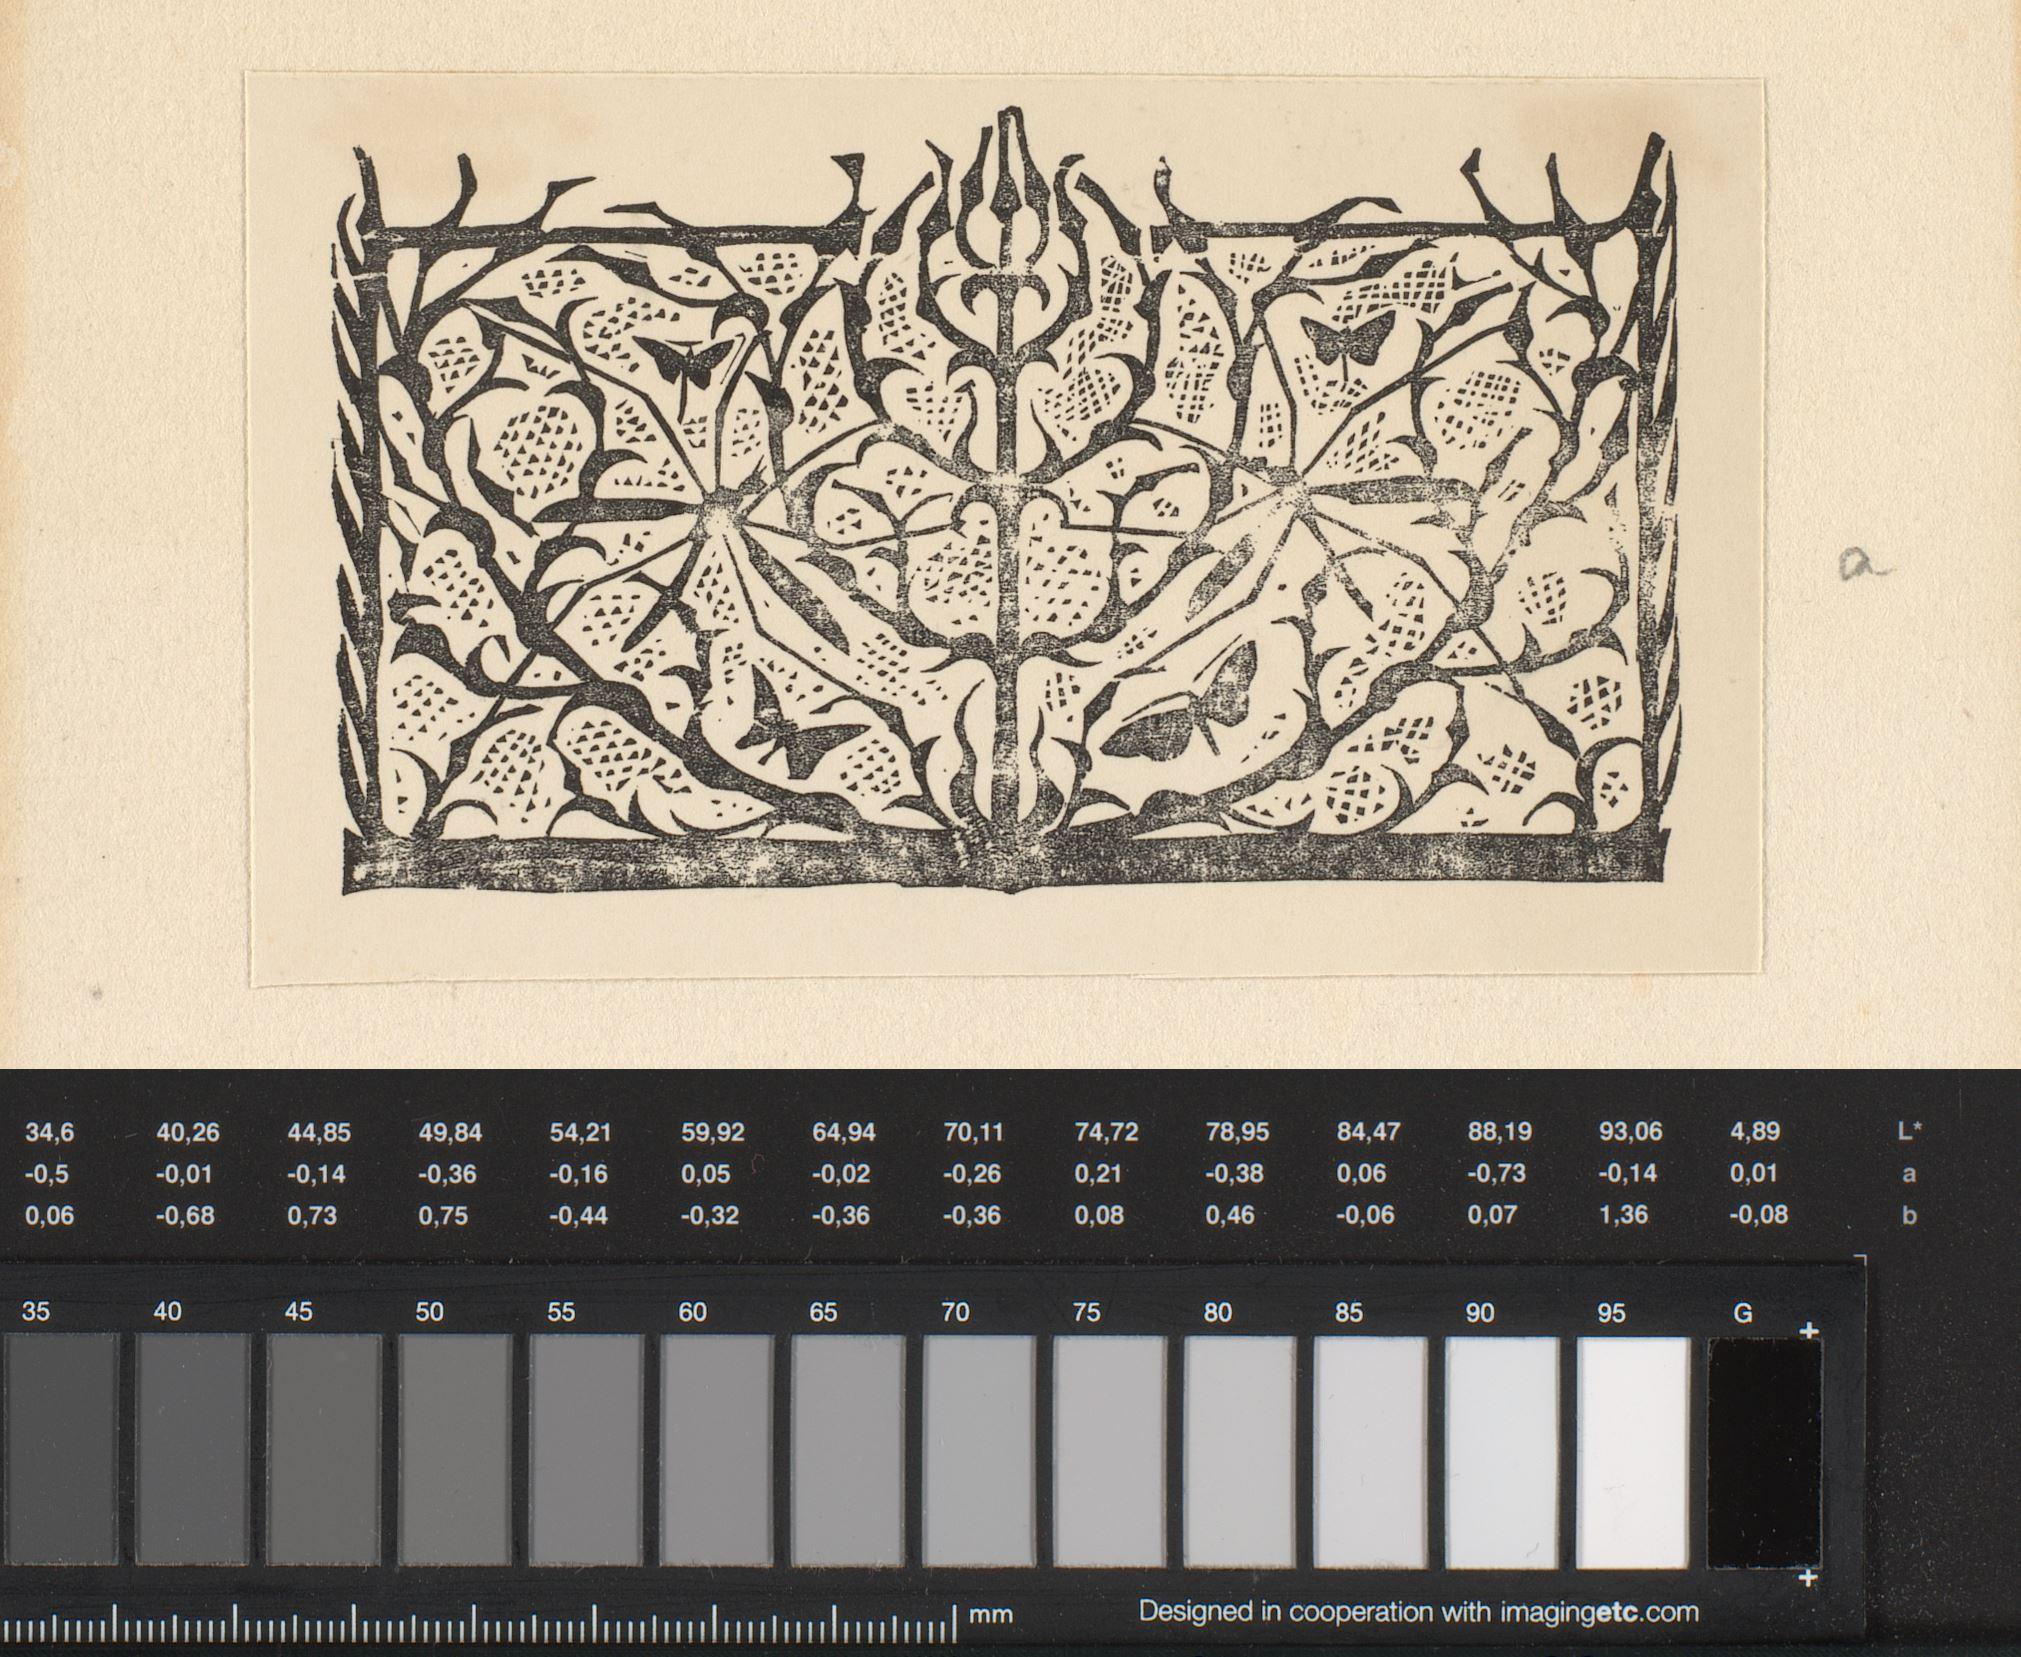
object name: print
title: Titelhoofd met langpootmuggen en motten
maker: gerrit willem dijsselhof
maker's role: designer, draughtsman, print maker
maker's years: 1866-1924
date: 1893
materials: paper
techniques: galvanoplasty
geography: haarlem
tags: insects: moth, insects: mosquito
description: Titelhoofd uit: Crane, Walter. Kunst en samenleving. [Vertaald uit het Engels door] Jan Veth. Amsterdam: Scheltema & Holkema's Boekhandel, 1894 [1893], p. 82. Later zijn deze afbeeldingen door de uitgever veelvuldig gebruikt voor andere uitgaven. Zie bijvoorbeeld RP-P-1969-415, een catalogus van de in 1894 bij Scheltema & Holkema's Boekhandel verkrijgbare publicaties.